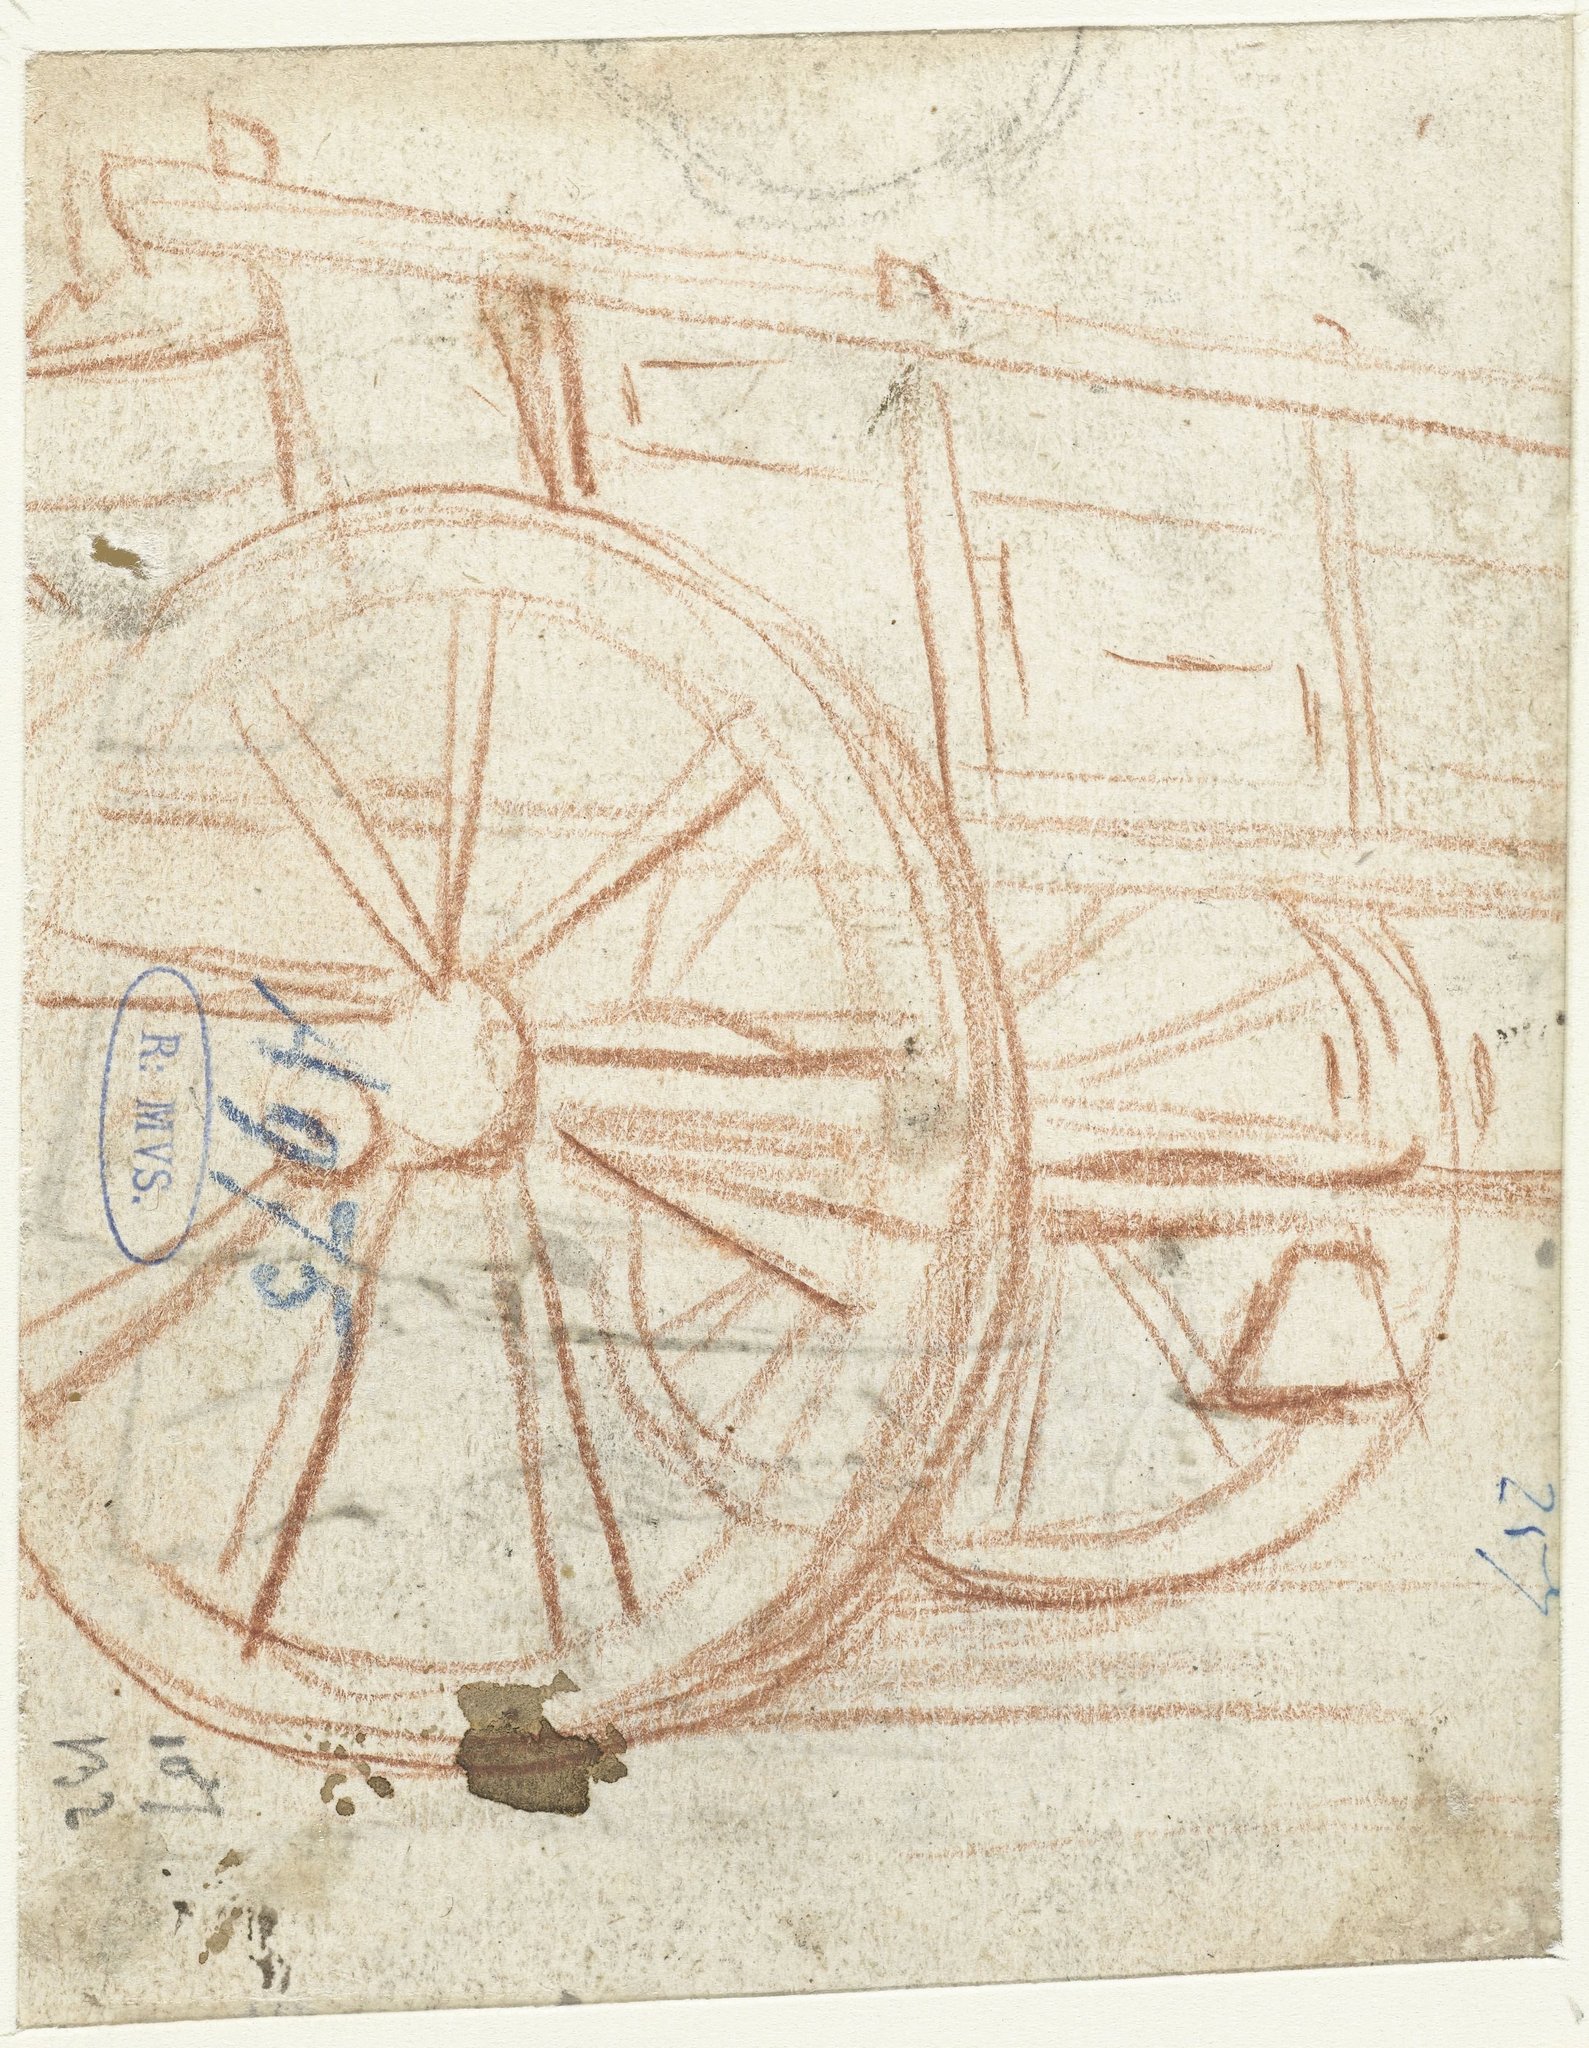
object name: drawing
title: Achterwielen van een wagen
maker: harmen ter borch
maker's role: draughtsman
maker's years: 1638-1677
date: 1650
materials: chalk, paper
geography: zwolle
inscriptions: date